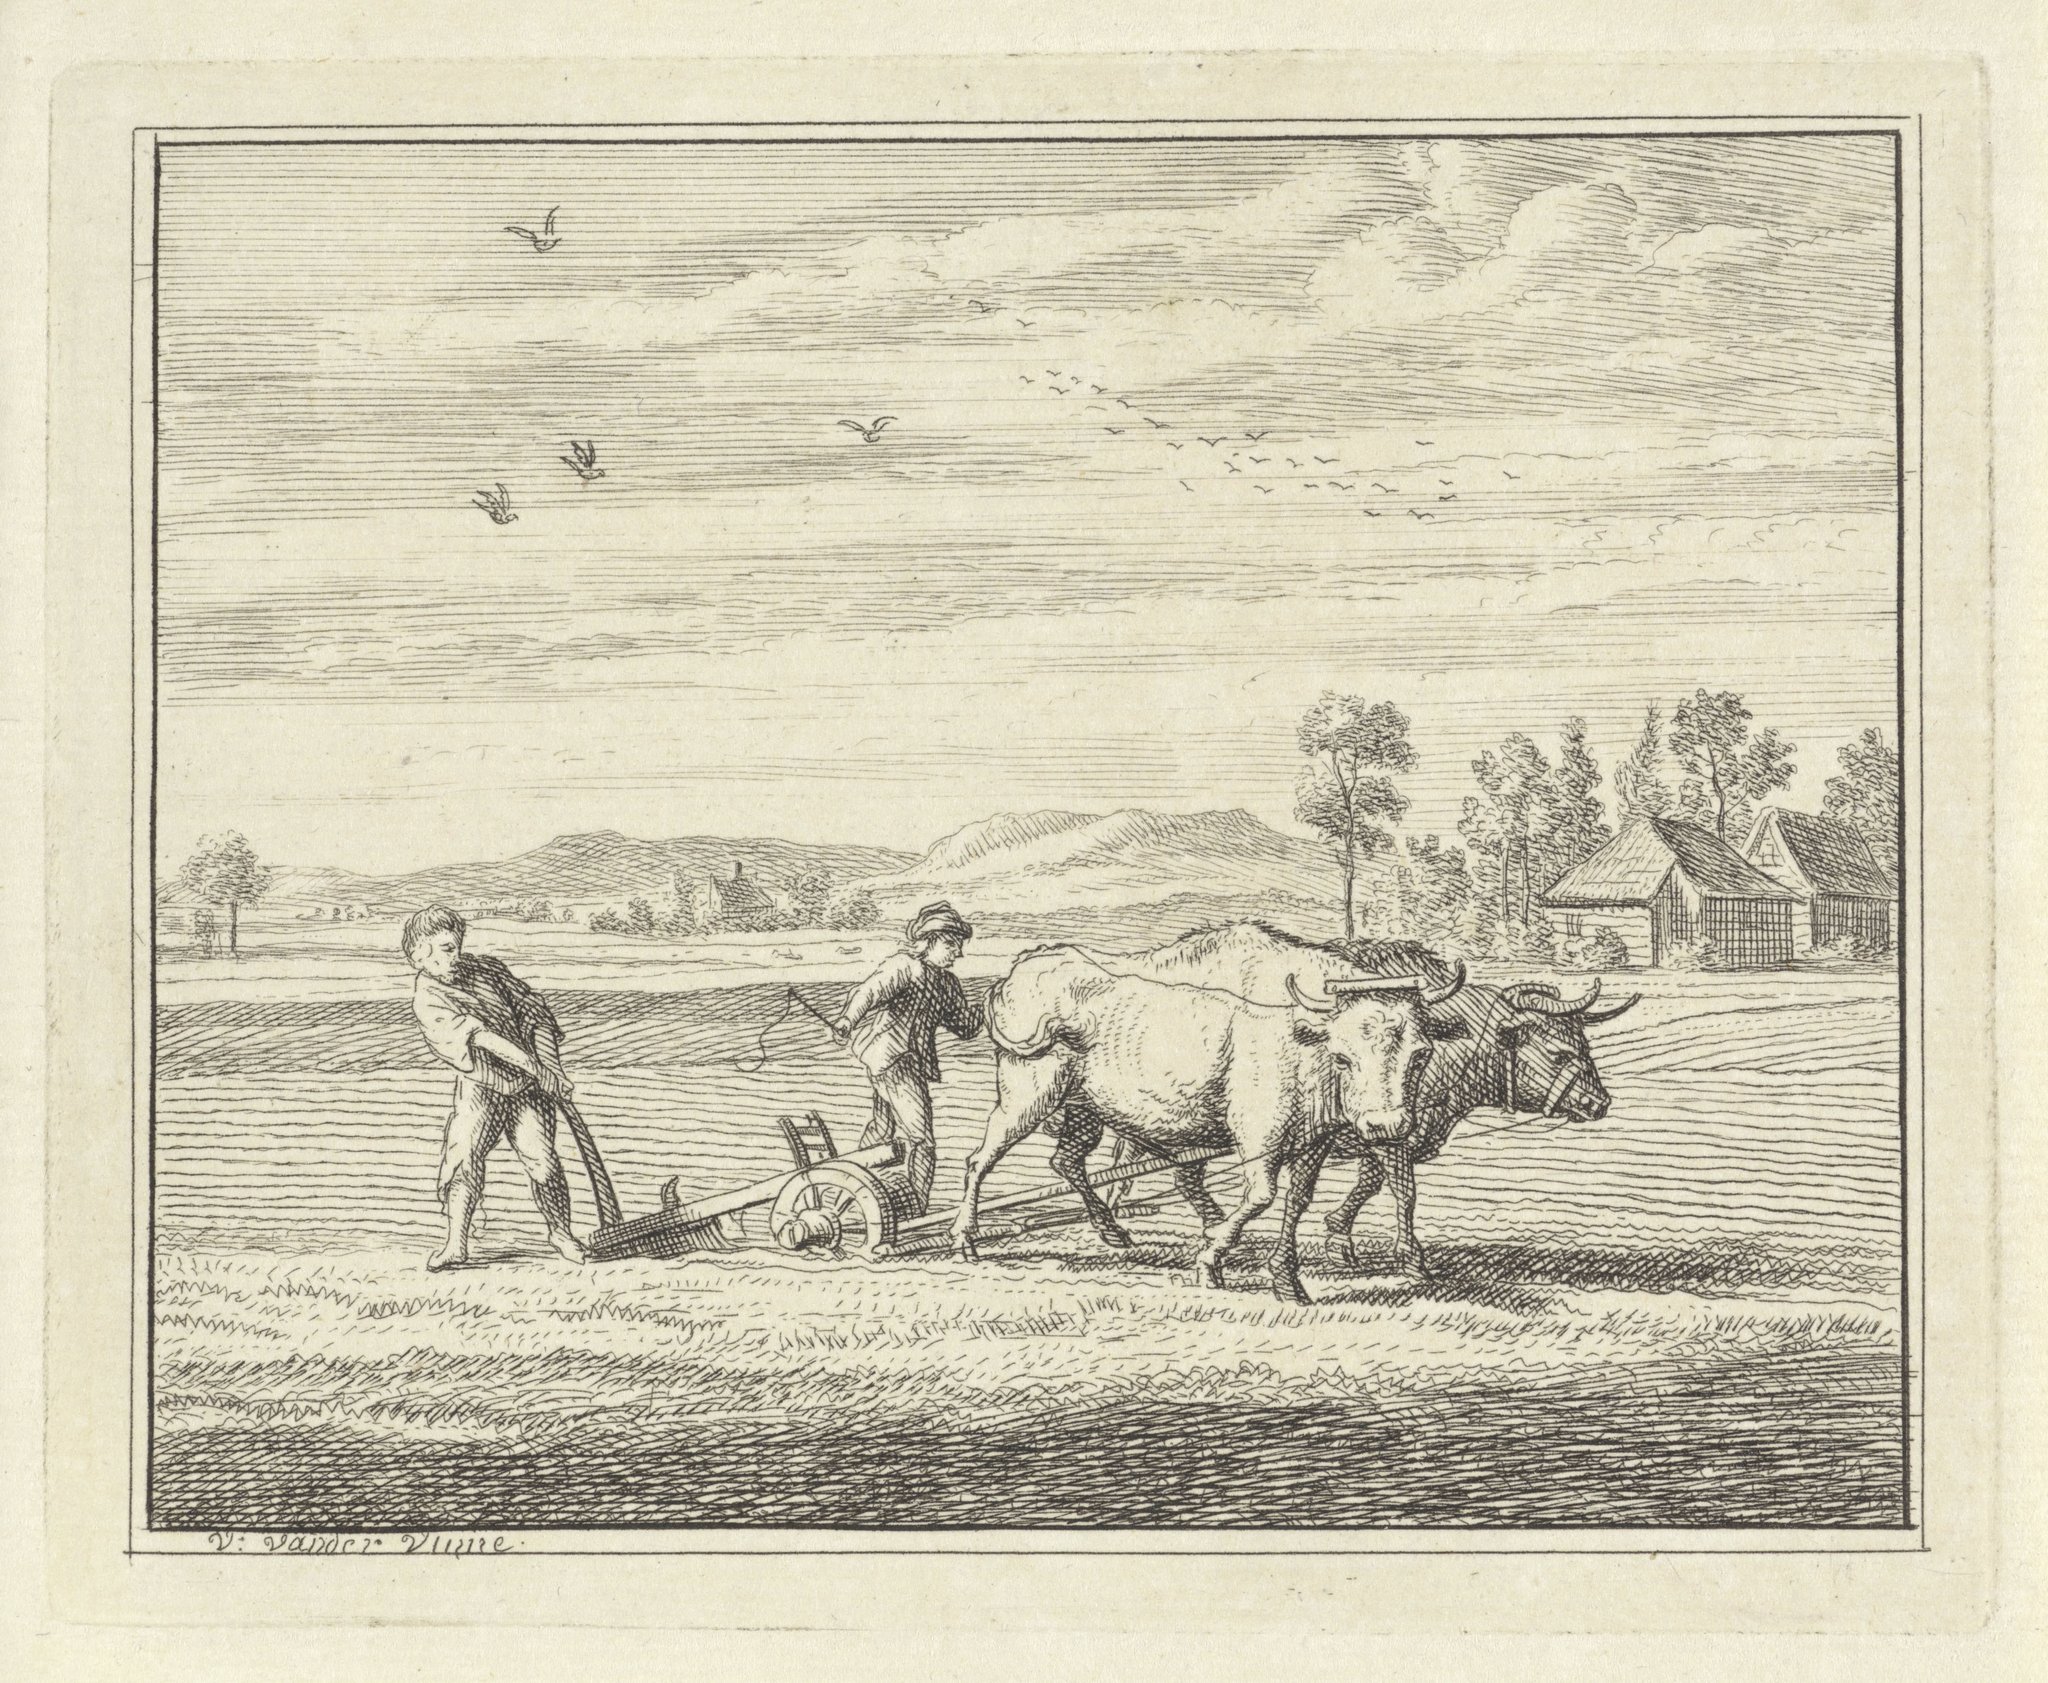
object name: print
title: Ploegende boeren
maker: vincent laurensz. van der vinne (ii)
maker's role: draughtsman, print maker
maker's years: 1686-1742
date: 1714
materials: paper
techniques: engraving, etching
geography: haarlem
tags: agricultural implements: plough, ploughing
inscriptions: collector's mark: Lugt 240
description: Prent oorspronkelijk bedoeld als boekillustratie voor: Spinniker, Adriaan. Leerzaame zinnebeelden. Haarlem: [boekverkoper] Isaak van der Vinne (I) en Amsterdam: [drukker] Johannes Krelius, 1714. Later gebruikt als boekillustratie in: Spinniker, Adriaan. Vervolg der leerzaame zinnebeelden, : spiegel der boetvaardigheid en genade en eenige Stichtelyke gezangen. Haarlem: Jan Bosch, 1758.